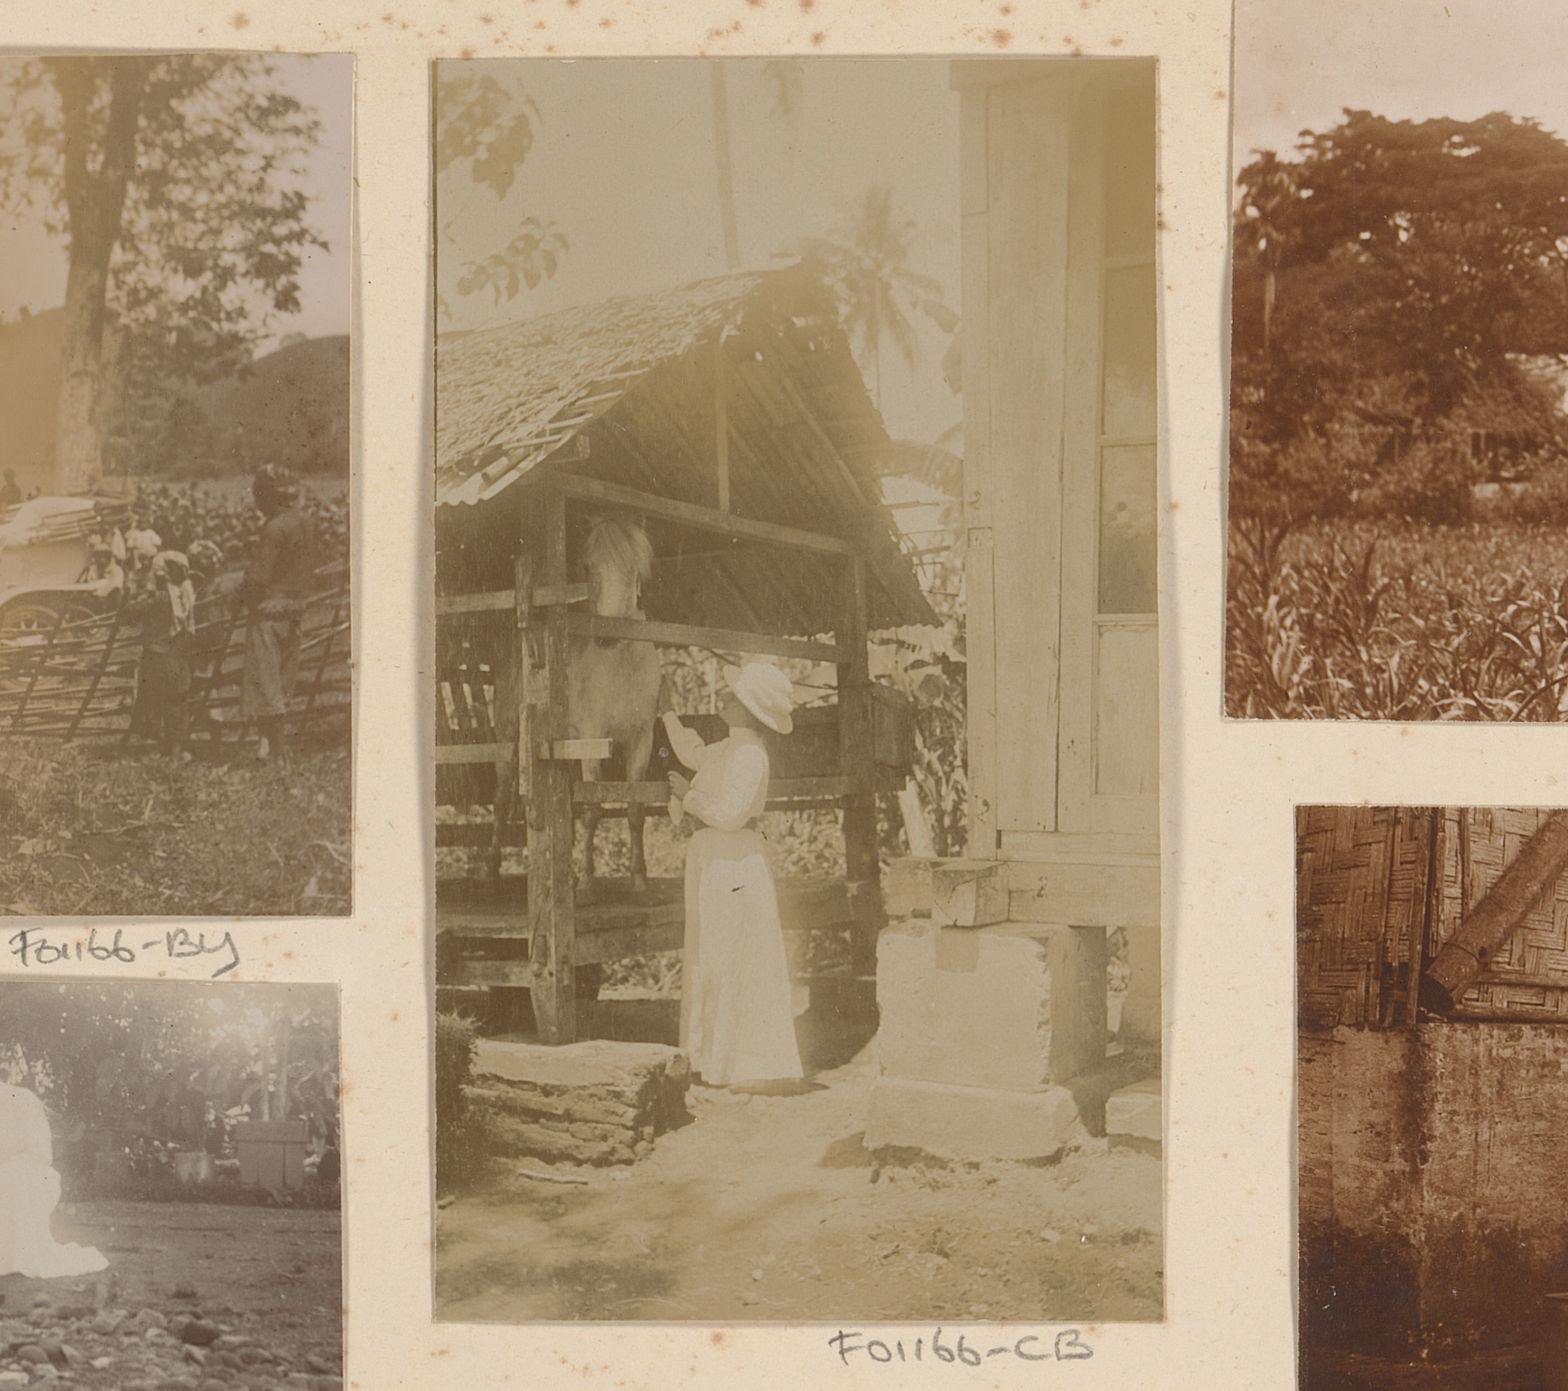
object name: album leaf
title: Nederlandse vrouw aait een paard in open stal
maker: Anonymous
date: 1880-1910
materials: photographic support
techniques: gelatin silver print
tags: barn, adult woman, historical persons, horse, dutch east indies, the